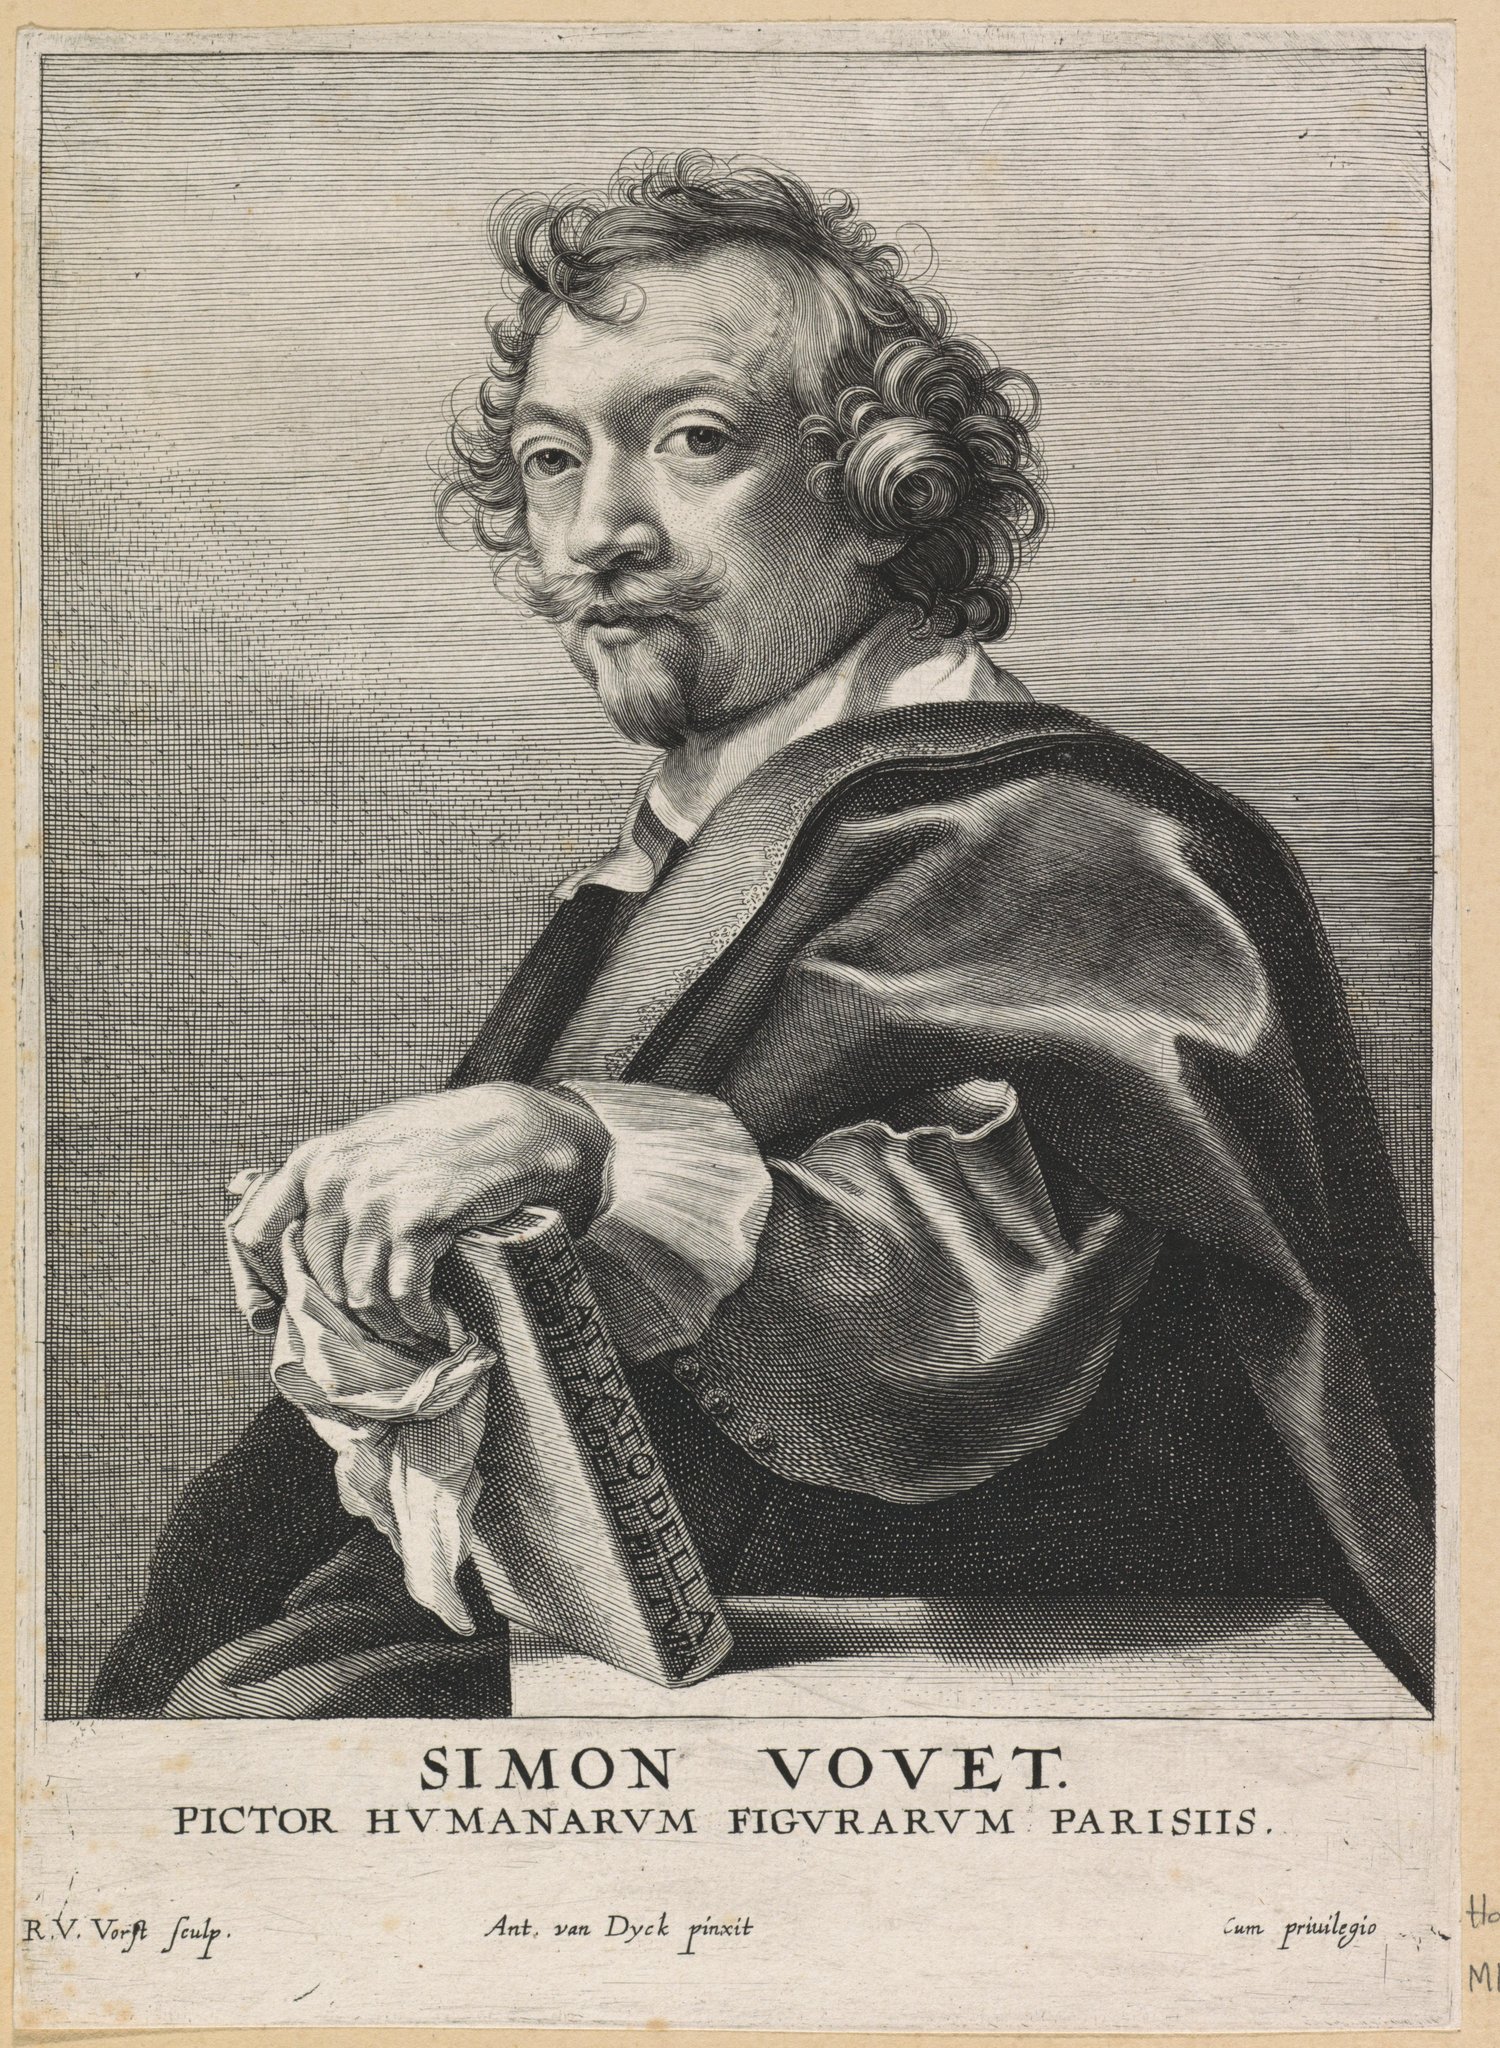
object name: print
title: Portret van Simon Vouet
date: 1627-1636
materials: paper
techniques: engraving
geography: london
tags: paris, print maker, draughtsman, simon vouet, book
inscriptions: collector's mark: Lugt 240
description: Portret van de Franse kunstenaar Simon Vouet, zijn hand rust op een boek.